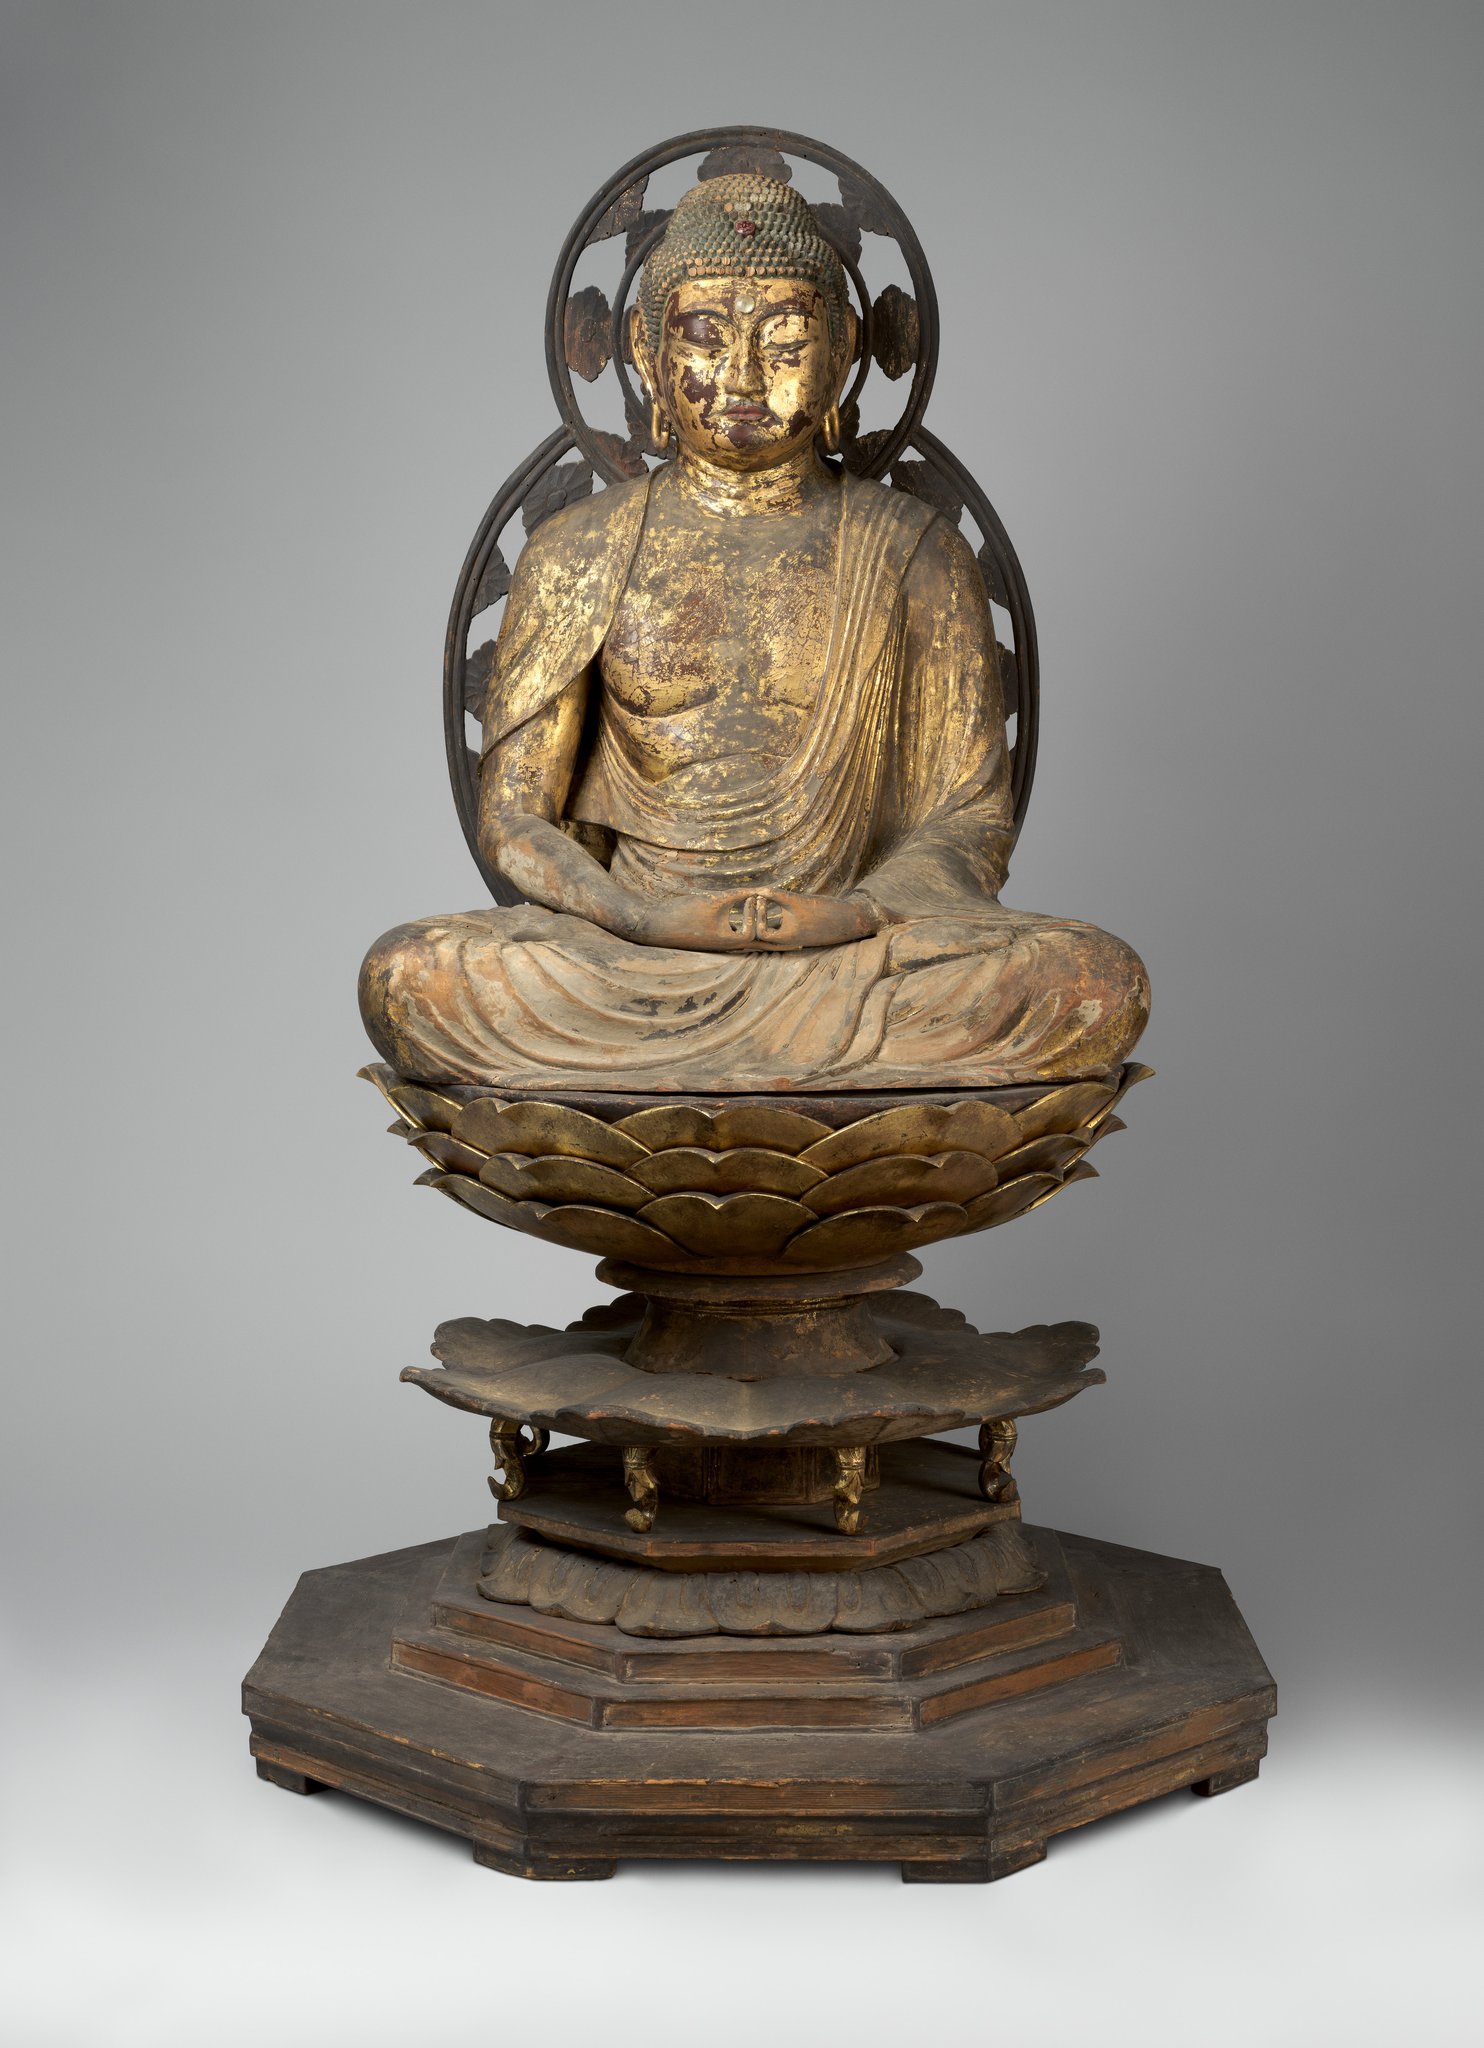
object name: statue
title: Amida, the Buddha of Limitless Light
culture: japanese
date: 1250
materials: gold leaf, lacquer, wood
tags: lotuses,buddhism,buddha